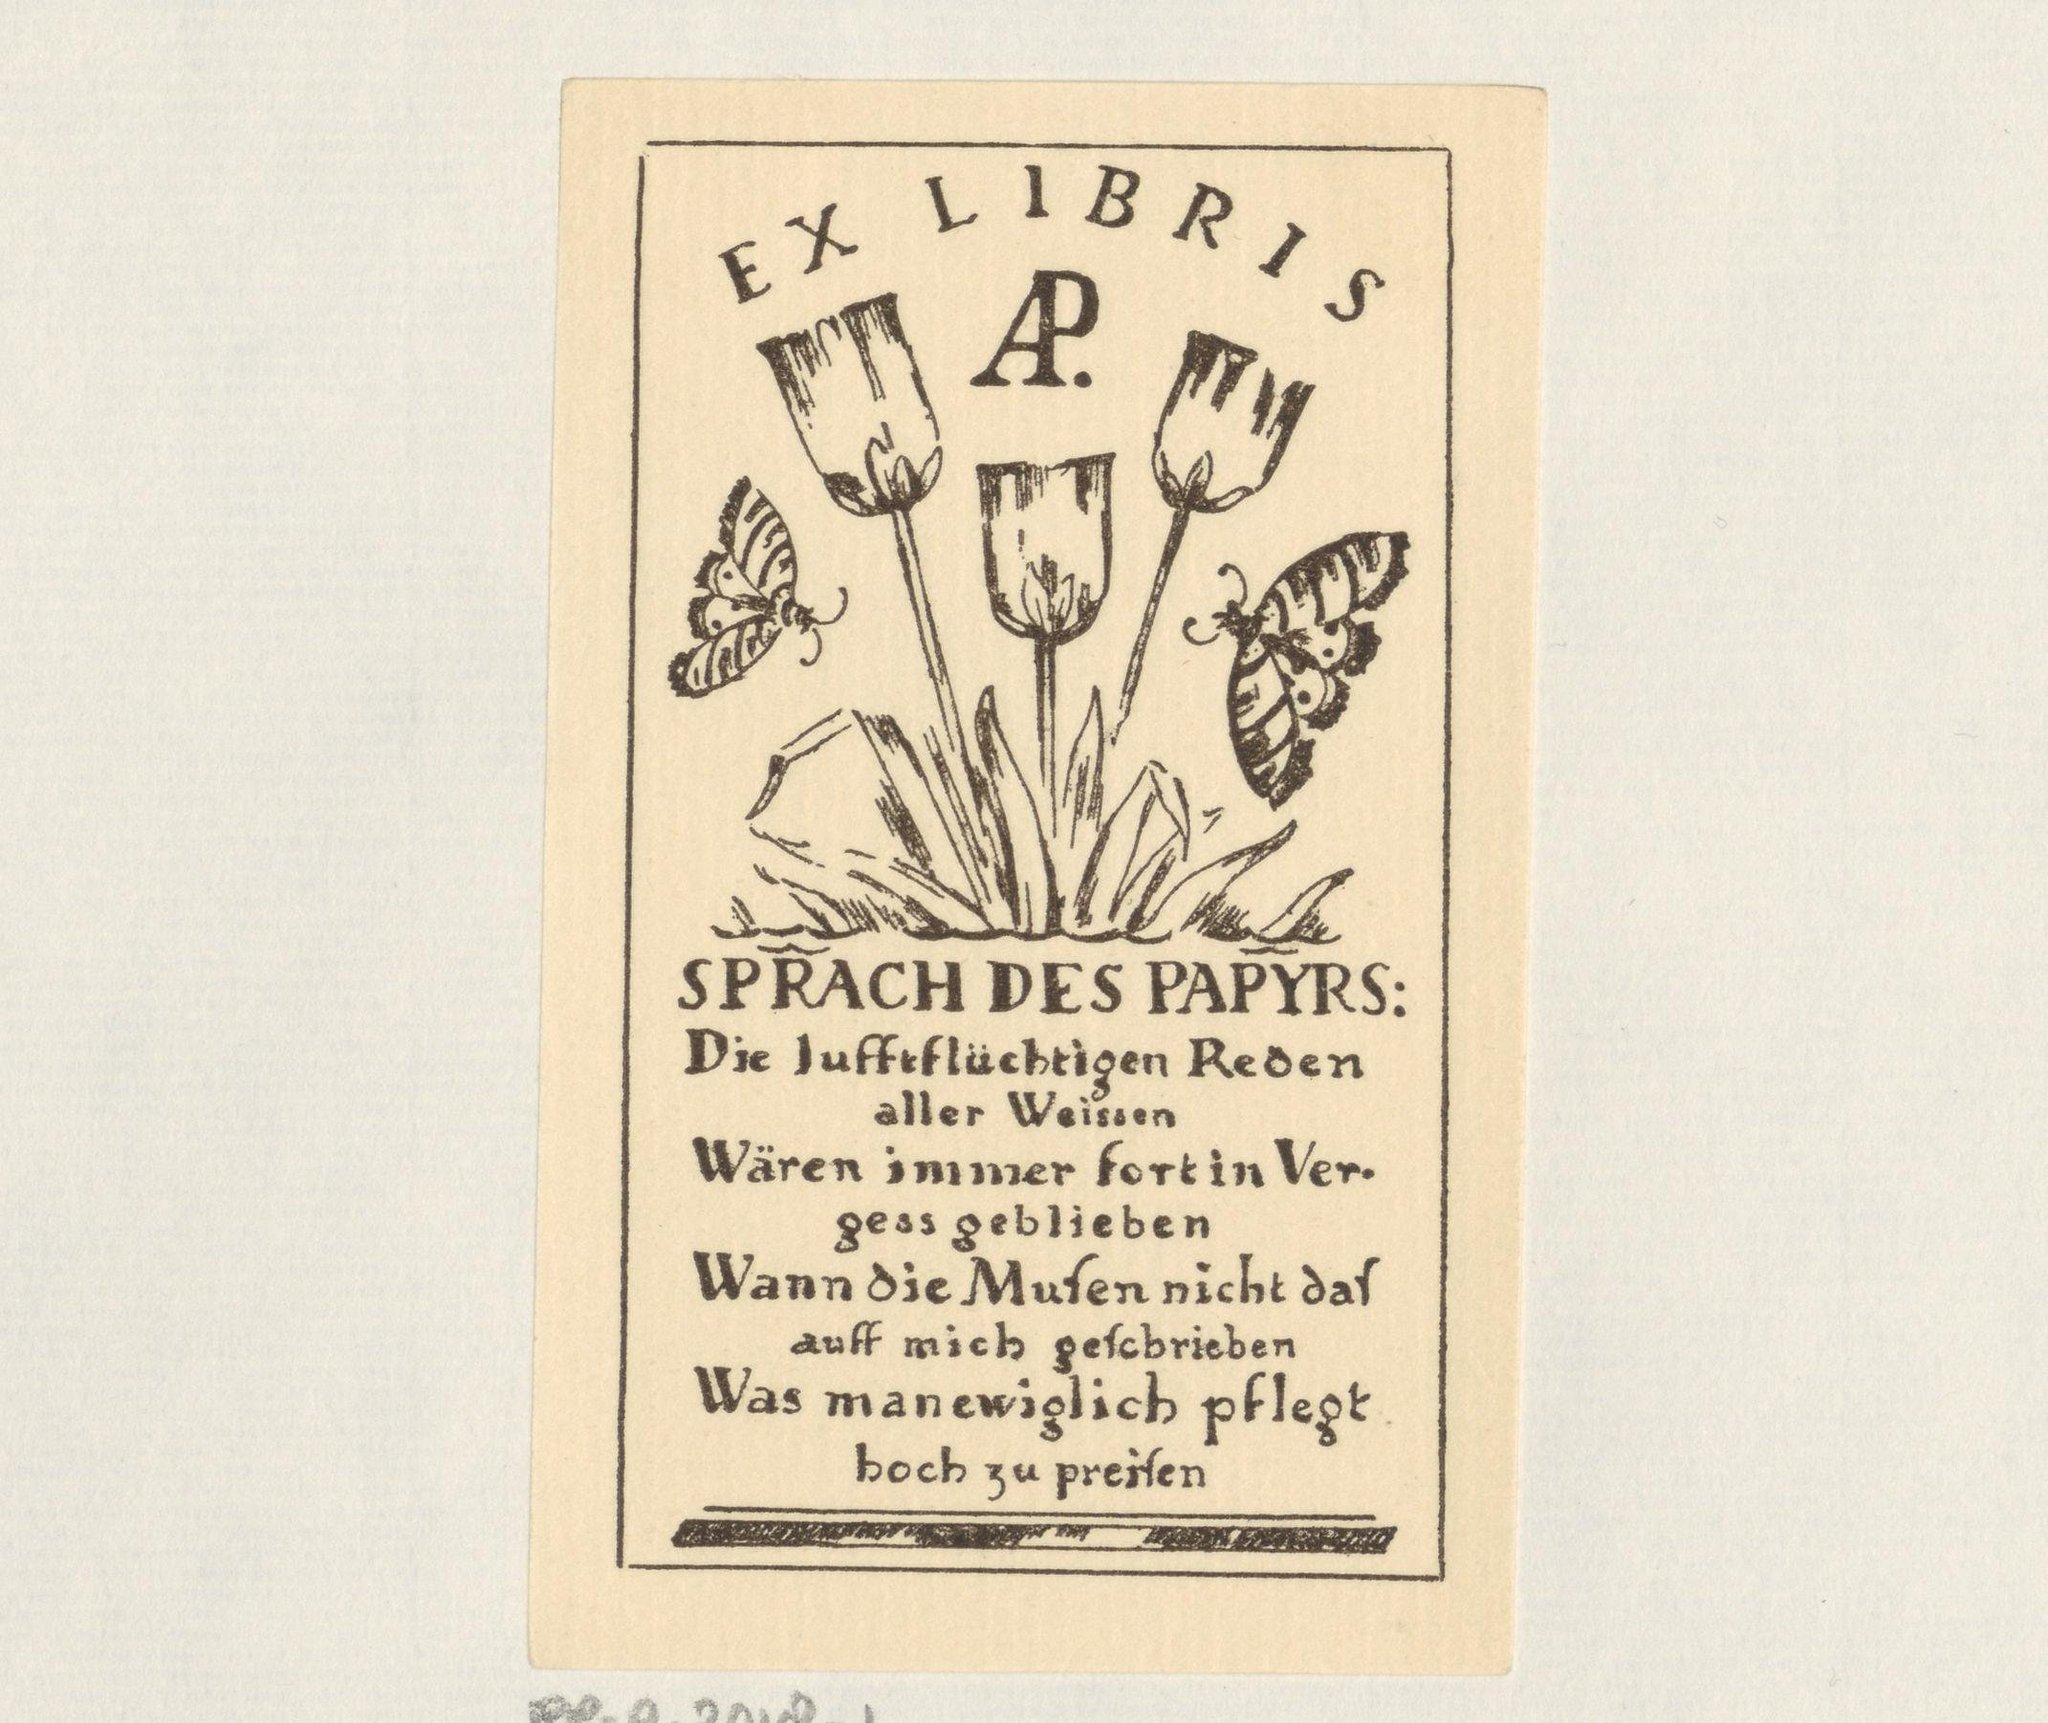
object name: bookplate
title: Sprach des Papyrs (...) hoch zu preisen.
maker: Anonymous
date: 1900-1999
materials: paper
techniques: printing block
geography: germany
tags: flowers, insects: butterfly